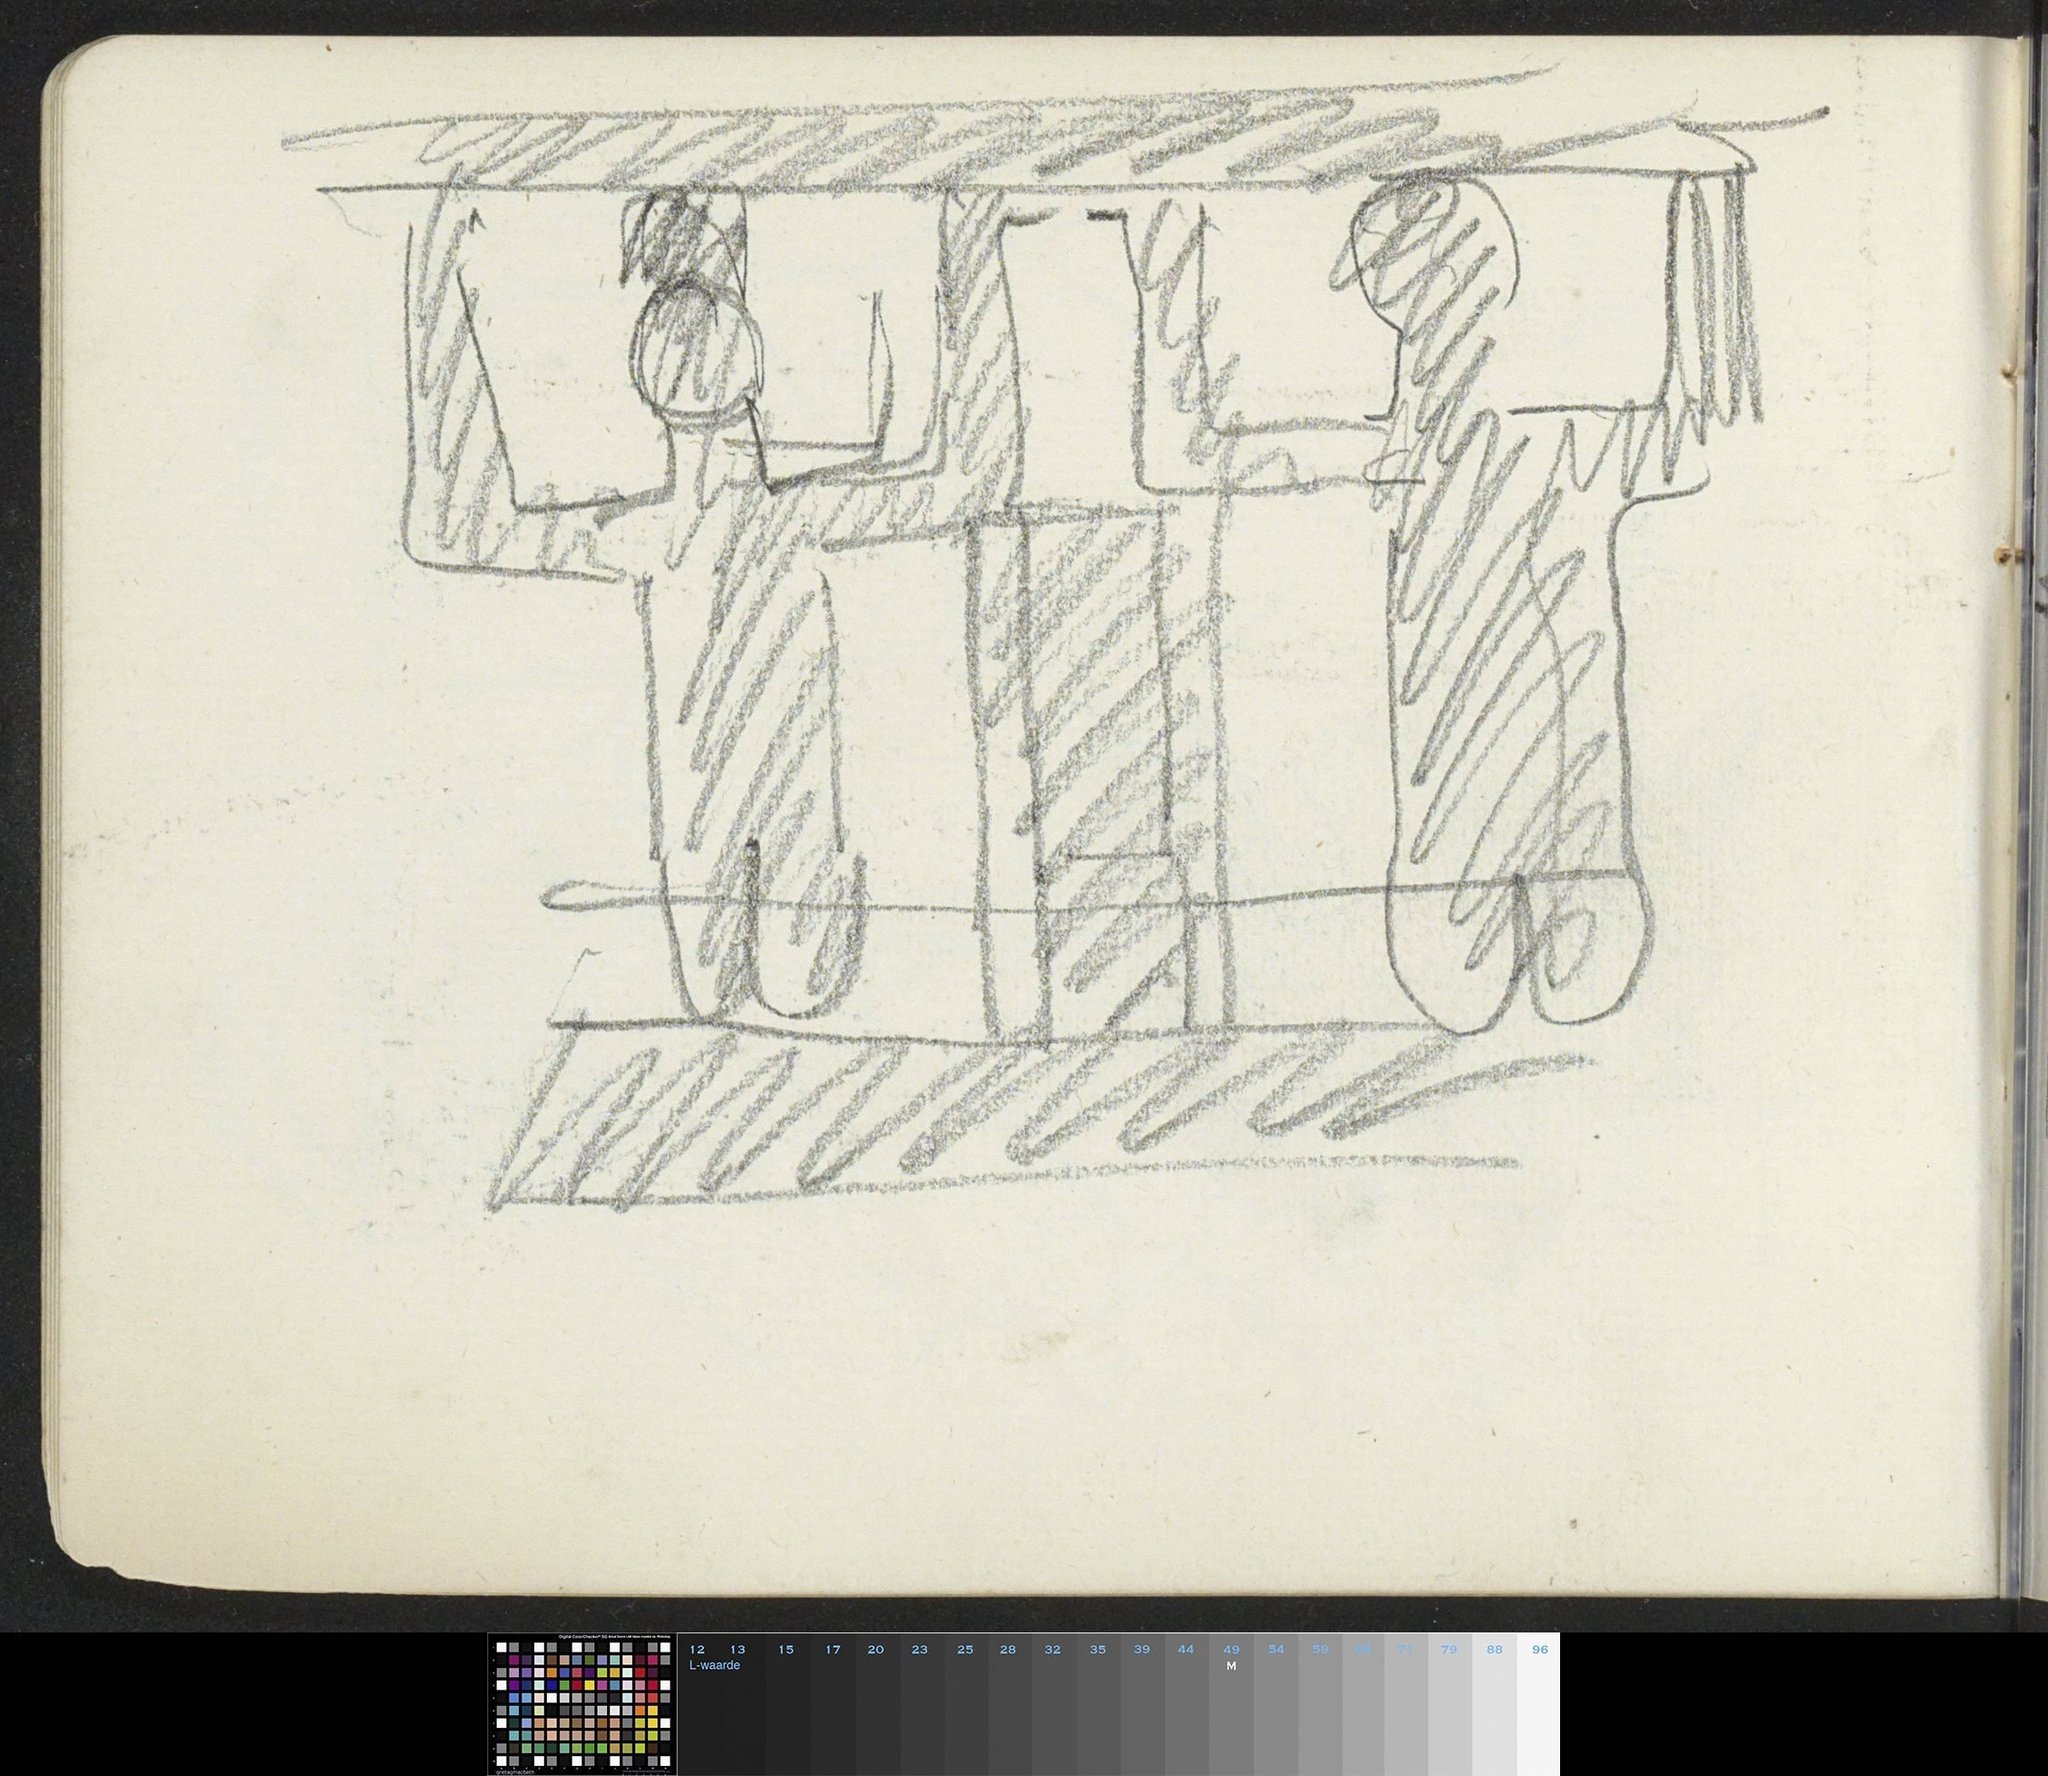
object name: sketchbook leaf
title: Ornament met twee figuren met opgeheven armen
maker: carel adolph lion cachet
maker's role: draughtsman, print maker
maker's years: 1864-1945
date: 1928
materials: paper, pencil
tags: ornaments ~ art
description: Met hun armen ondersteunen de figuren een balk. Blad 4 verso uit een schetsboek met 24 bladen.